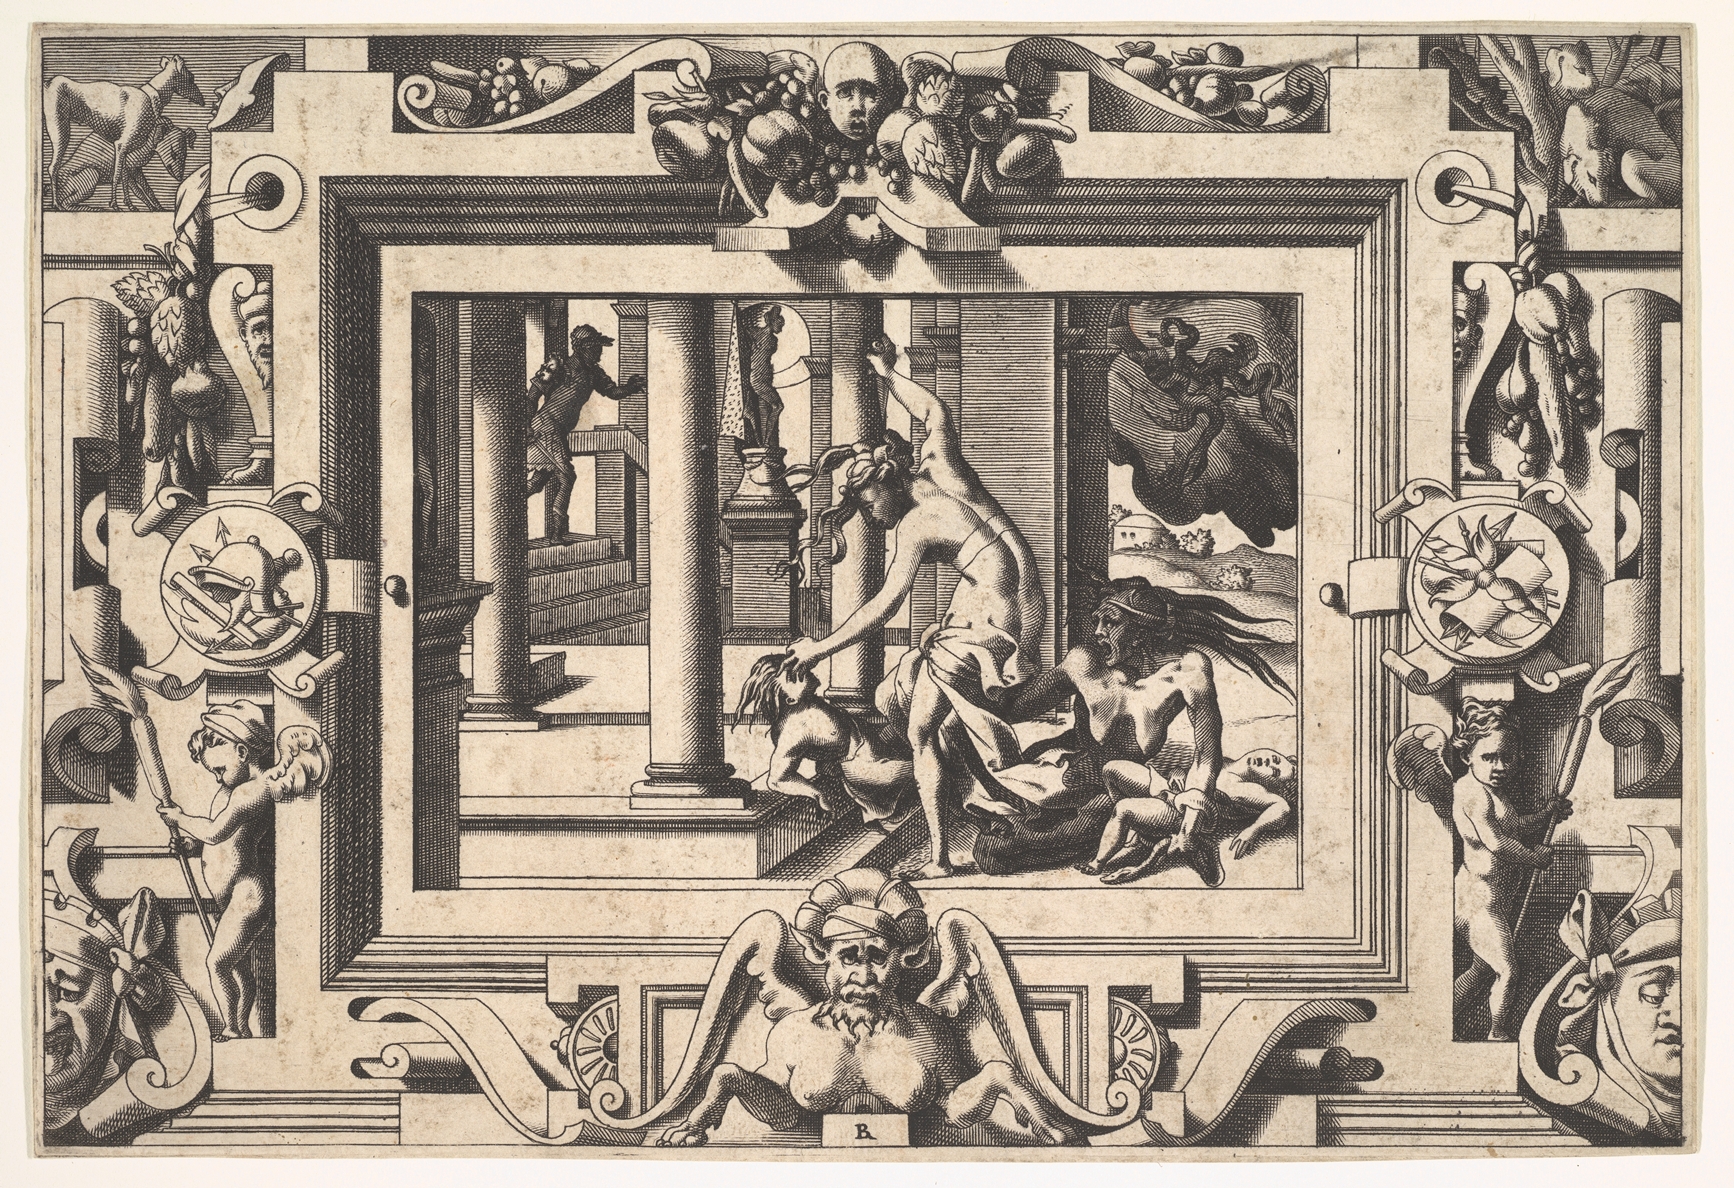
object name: print ornament architecture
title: Medea Kills her Two Children by Jason (Pour qui d'Absyrte a le sang repandu, fait que du sien le tort lui soit rendu...), from "Jason and the Golden Fleece"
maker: rené boyvin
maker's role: artist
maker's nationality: french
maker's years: 1525-1598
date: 1563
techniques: engraving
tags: suffering,children,medea,putti